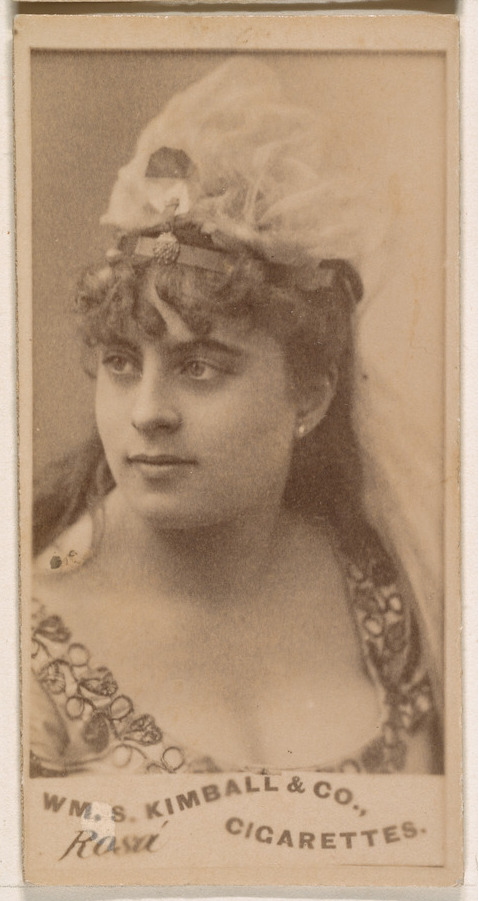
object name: photograph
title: Miss Rosa, from the Actresses series (N203) issued by Wm. S. Kimball & Co.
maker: william s. kimball & company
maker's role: publisher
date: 1889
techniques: color lithograph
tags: portraits,women,actresses